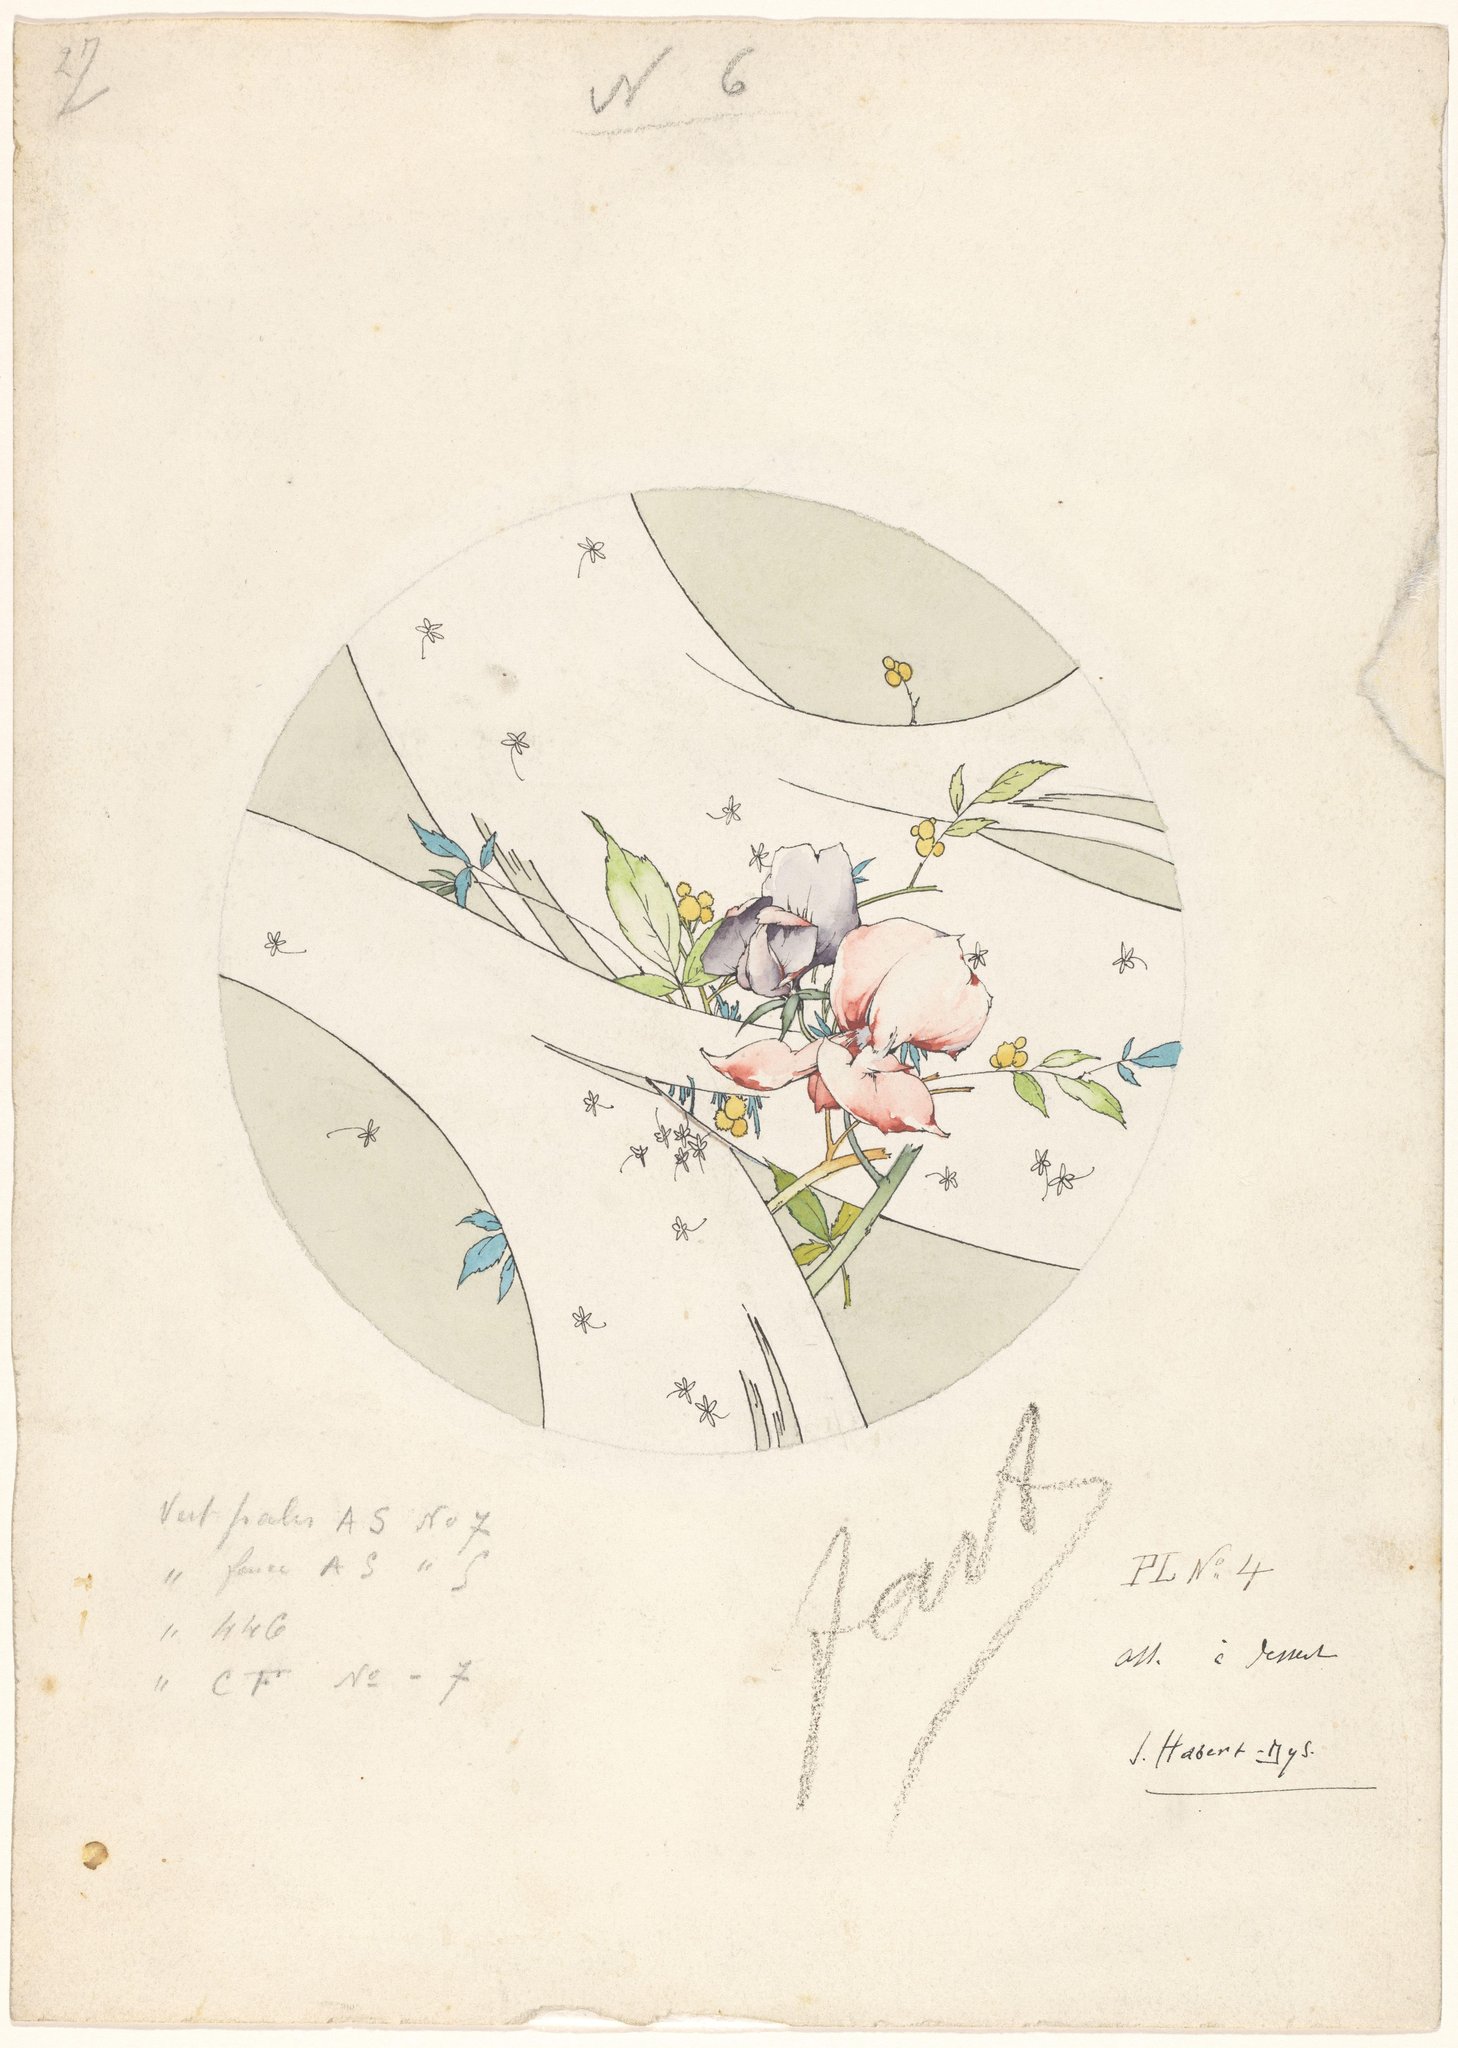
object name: drawing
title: Ontwerp voor een dessertbord van een porseleinen servies voor Pillivuyt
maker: jules auguste habert-dys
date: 1889-1890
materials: graphite, ink, paper, watercolor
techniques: brush, pen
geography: sèvres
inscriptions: inscription: ‘vert pales AS N0 7 / " fonce AS " 5 / " 446 / " CF No. - 7’, number: ‘7’, inscription: ‘PL No. 4 / ass. à dessert’, inscription: ‘fait’, number: ‘N 6’, signature: ‘J. Habert-Dys’, inscription: ‘Nos. 1.2.3.4.5.6.7 / serie de complément / recue le 19 Août 1890’, number: ‘27’